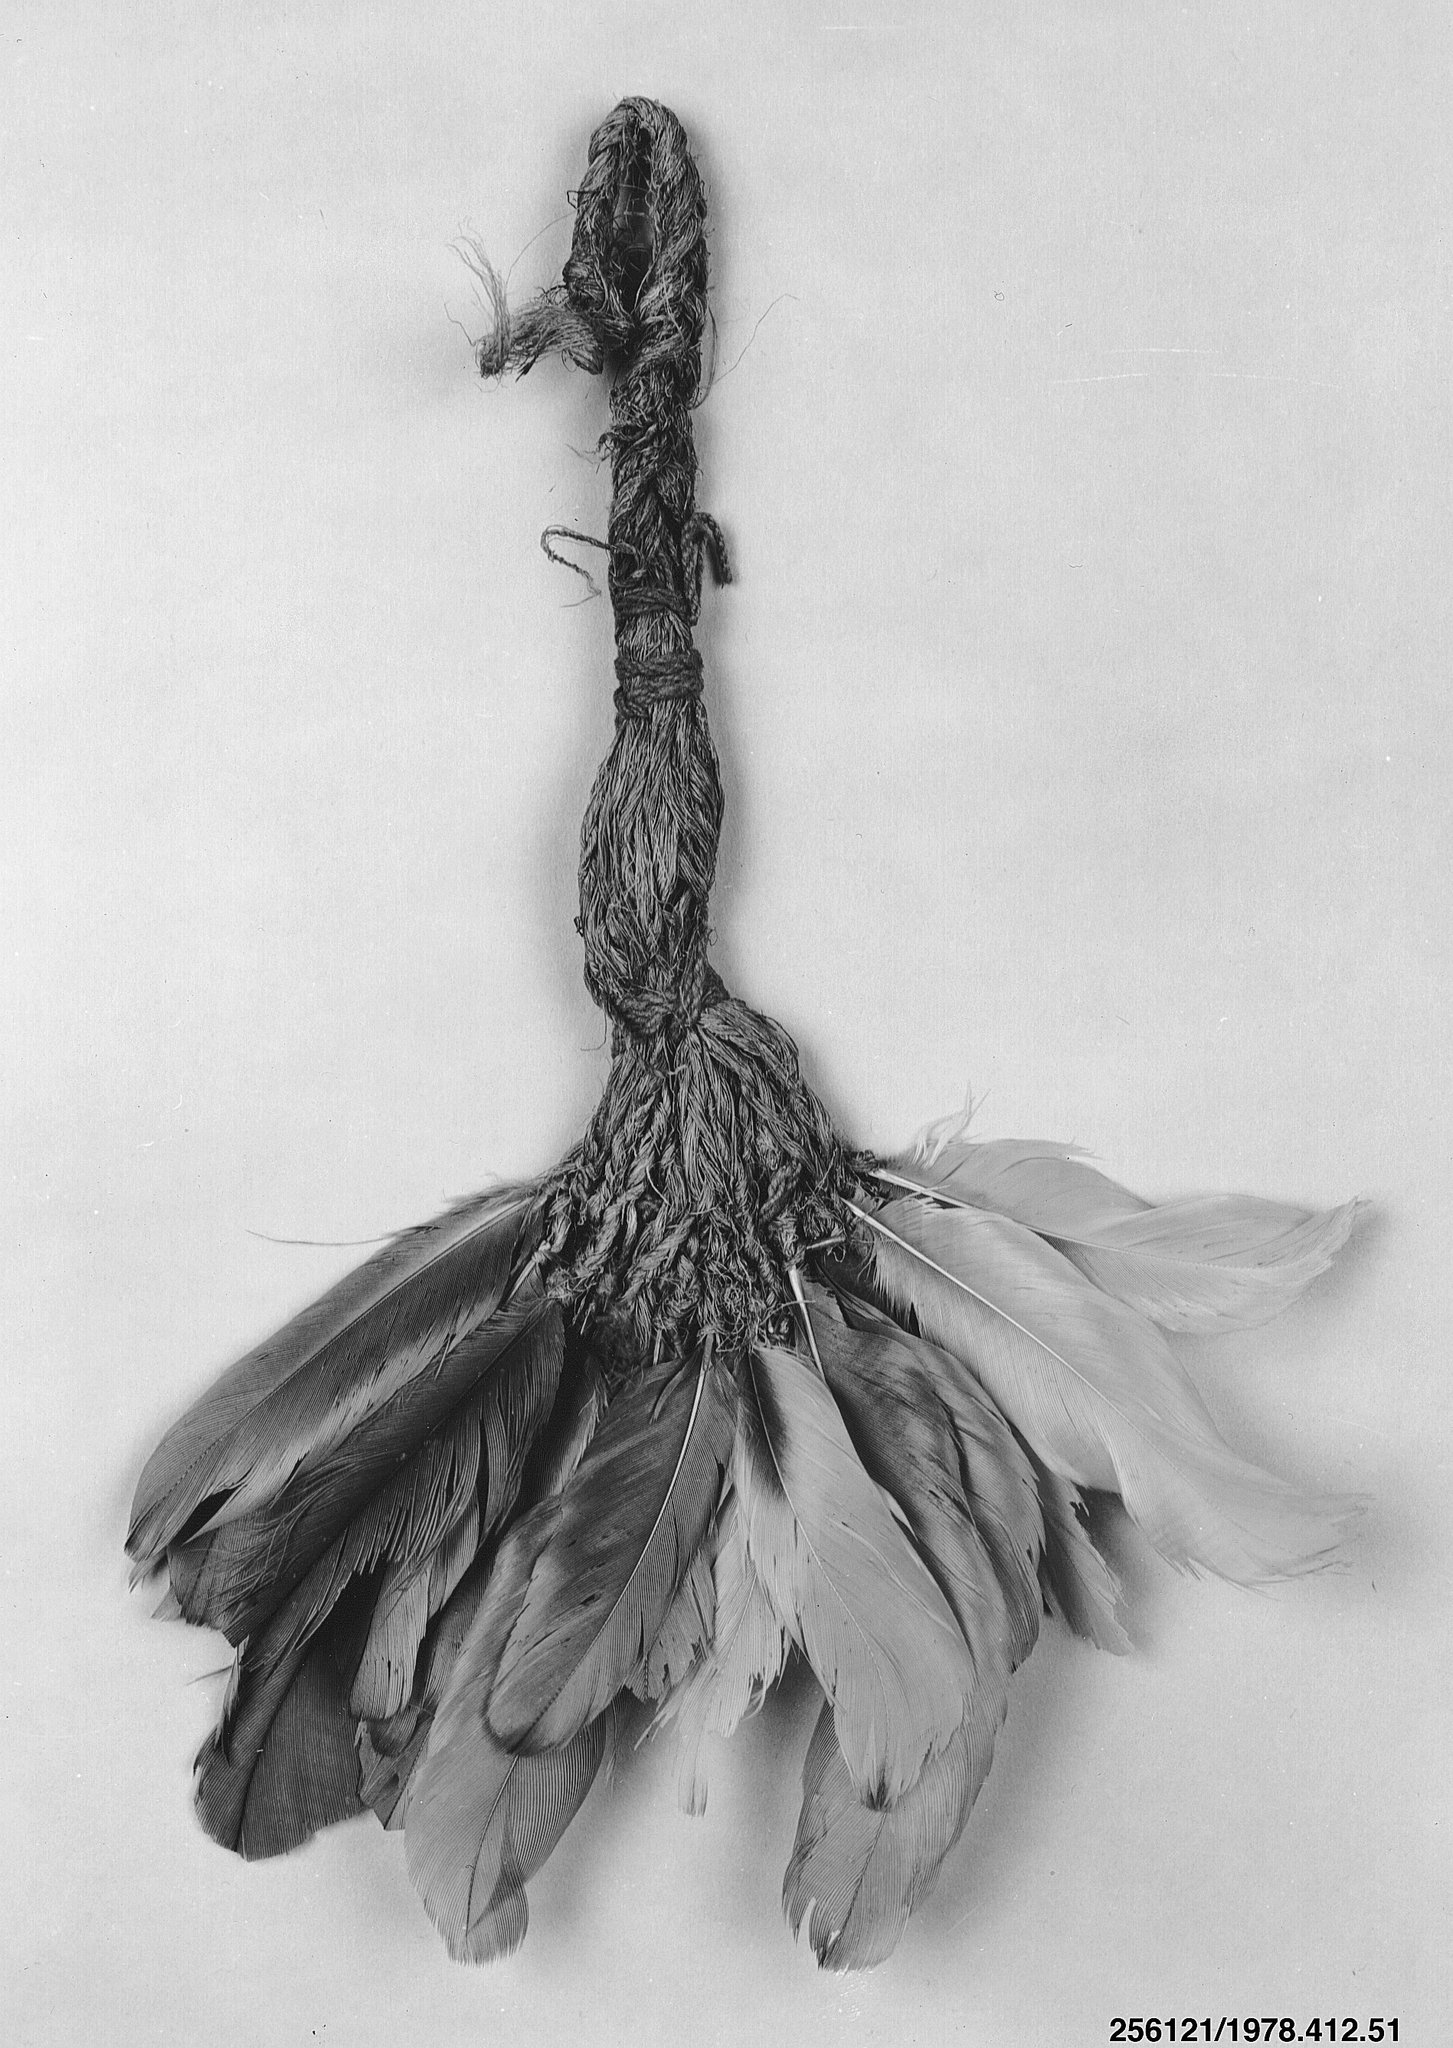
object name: ornament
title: Feathered Ornament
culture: central or south coast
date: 1001-1500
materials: cotton, feather, fiber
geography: peru